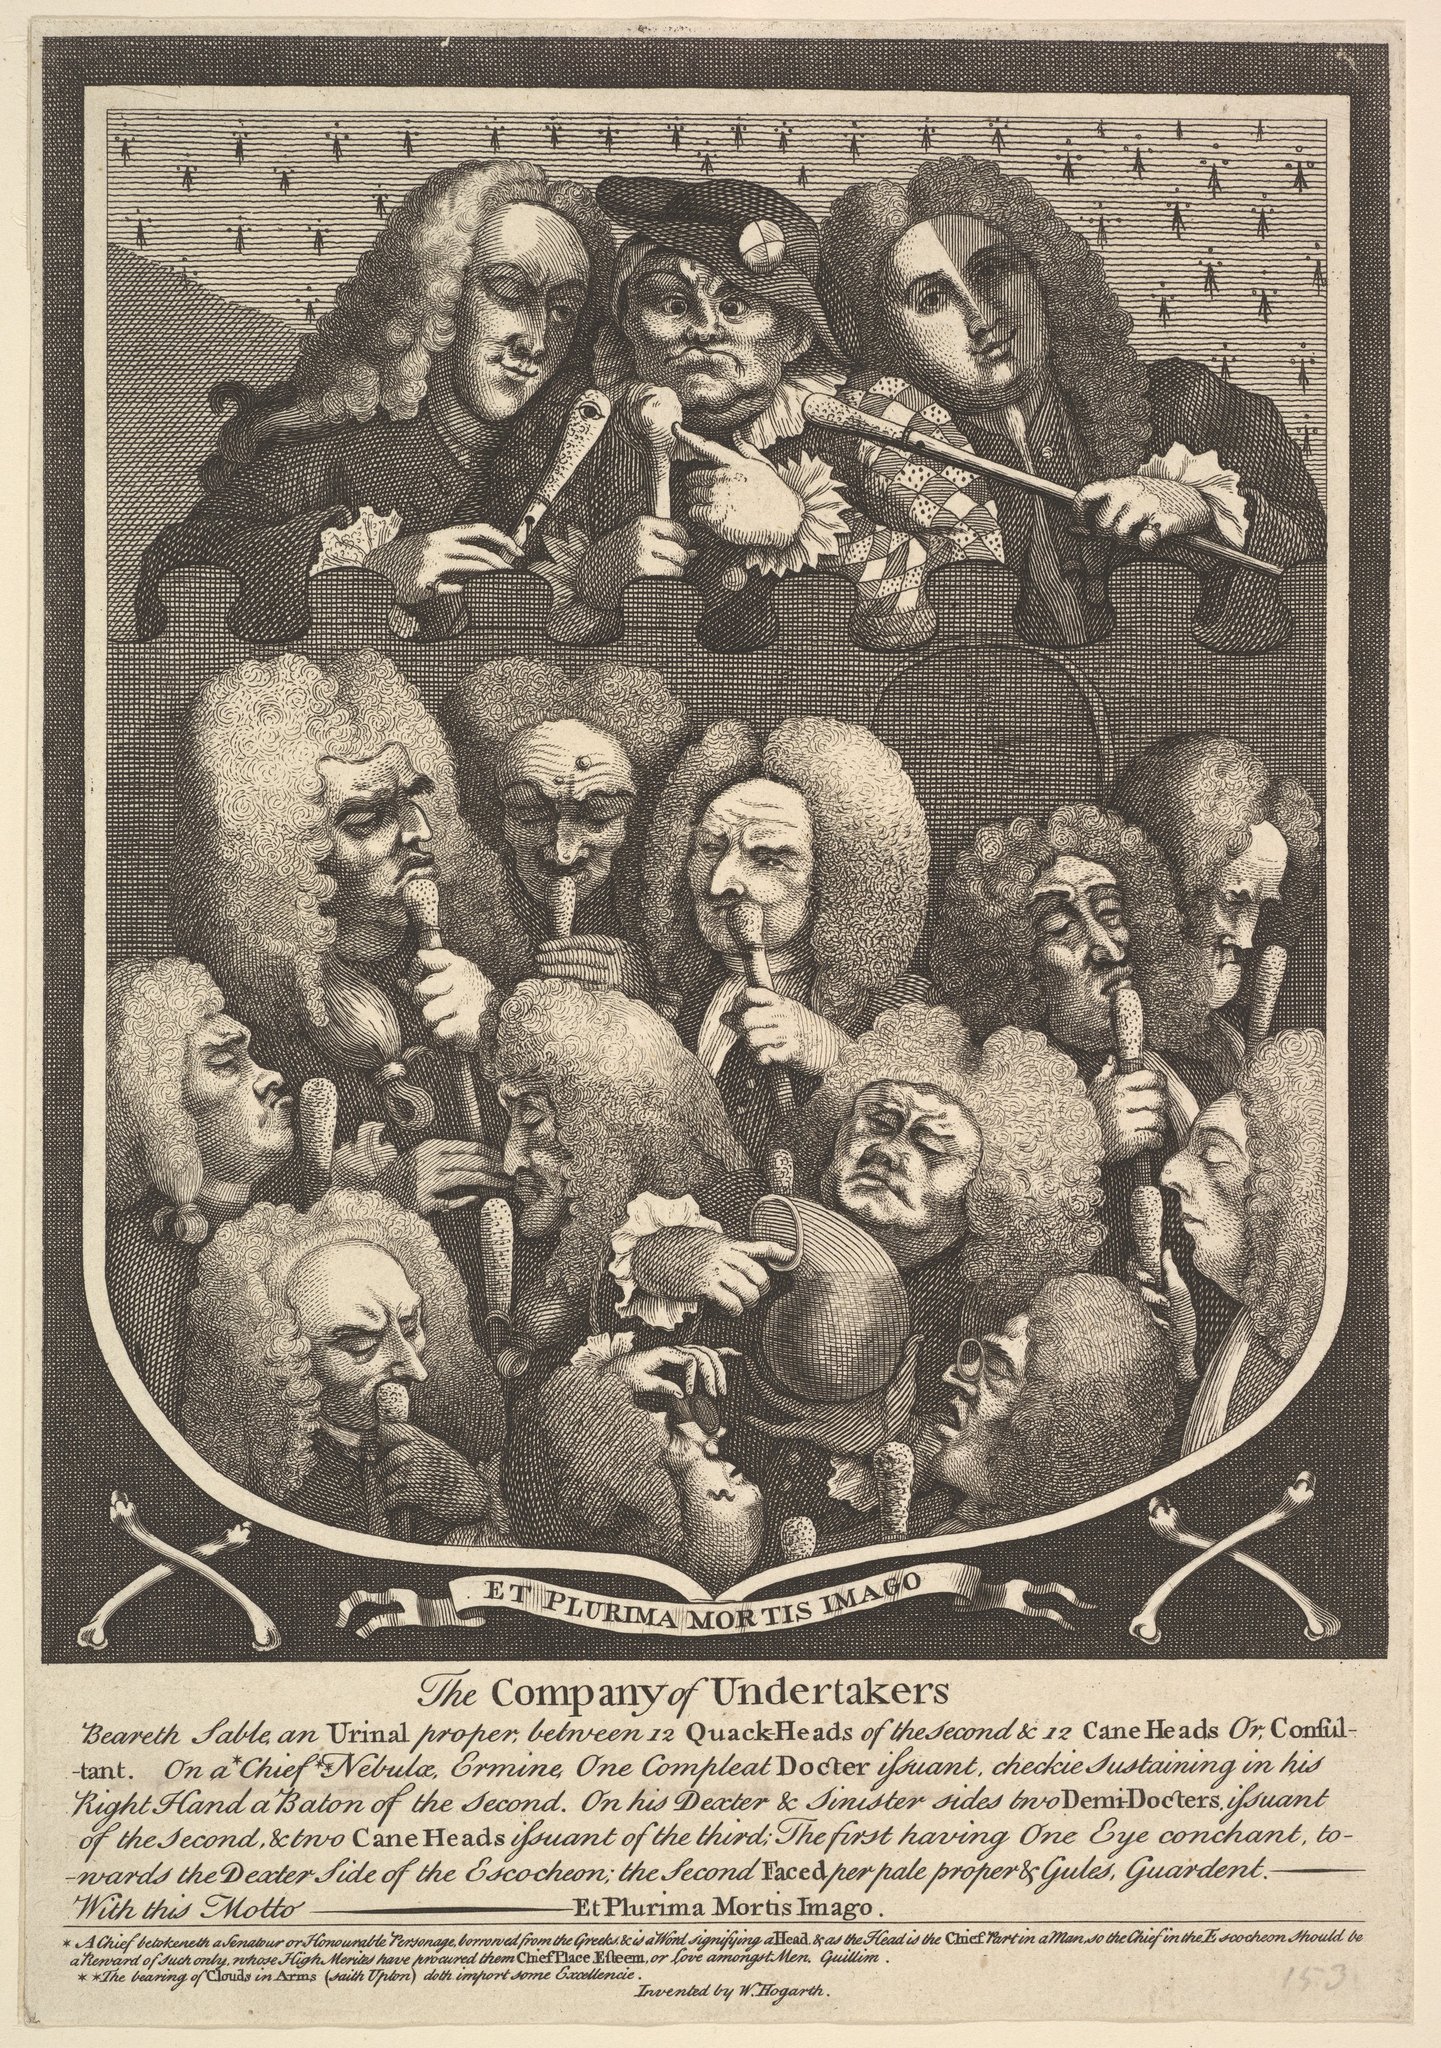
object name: print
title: The Company of Undertakers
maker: william hogarth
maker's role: artist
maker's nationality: british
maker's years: 1697-1764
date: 1736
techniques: engraving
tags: men